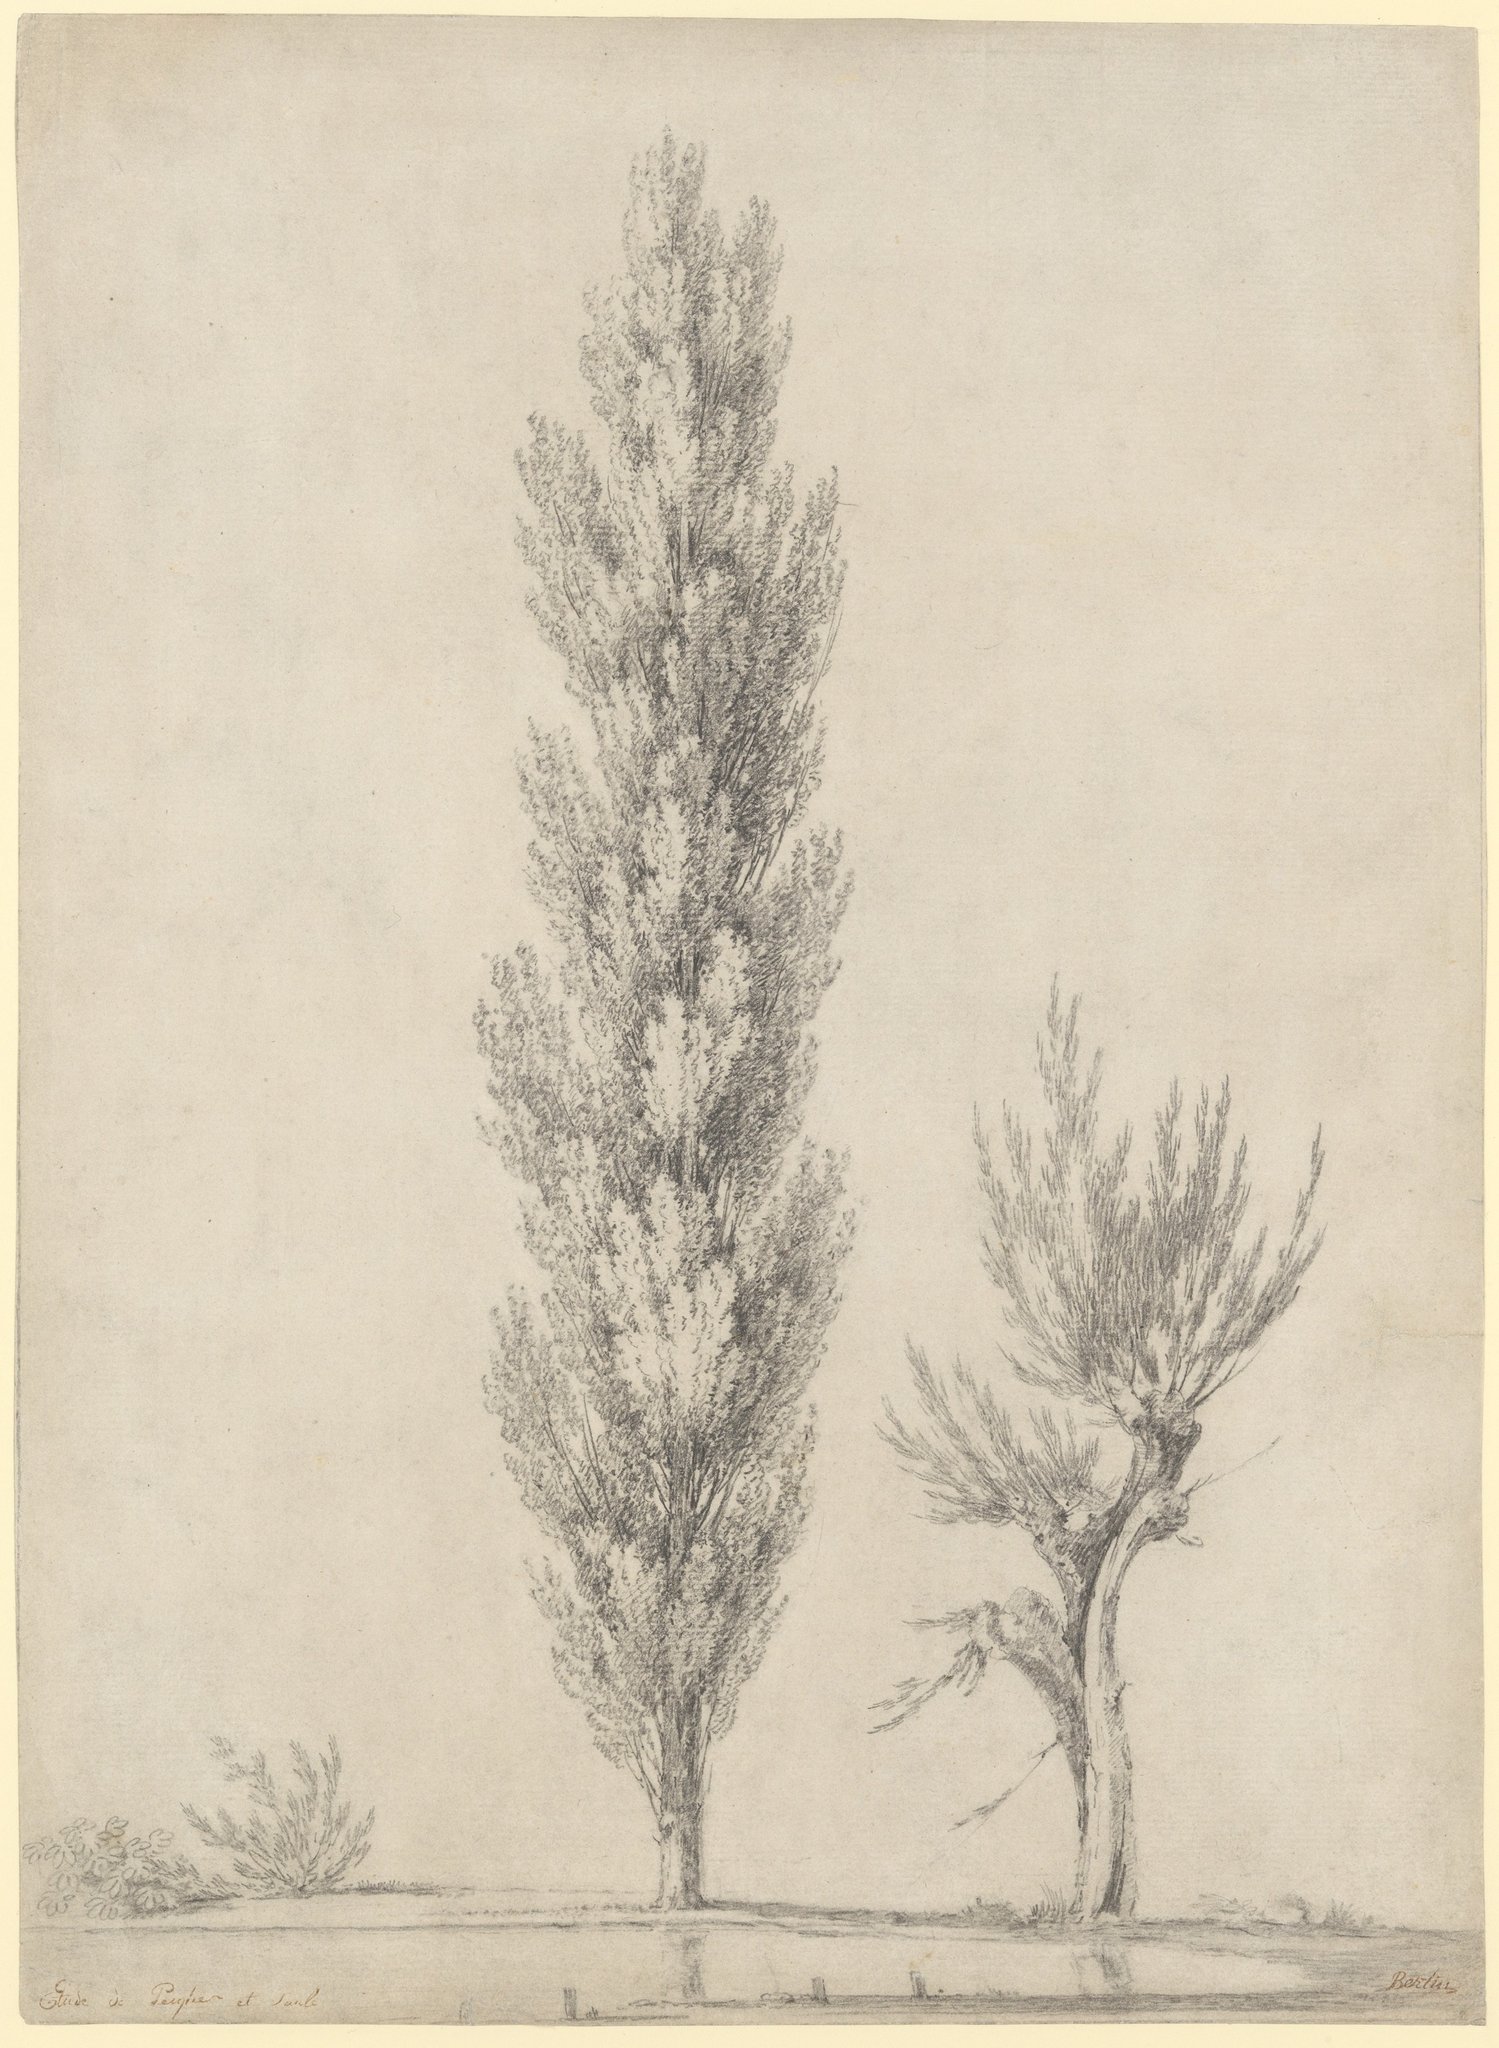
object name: drawing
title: Landscape with a Poplar and a Willow Tree at the Edge of a Pond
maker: jean victor bertin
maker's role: artist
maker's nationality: french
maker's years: 1767-1842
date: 1787-1842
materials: chalk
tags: trees